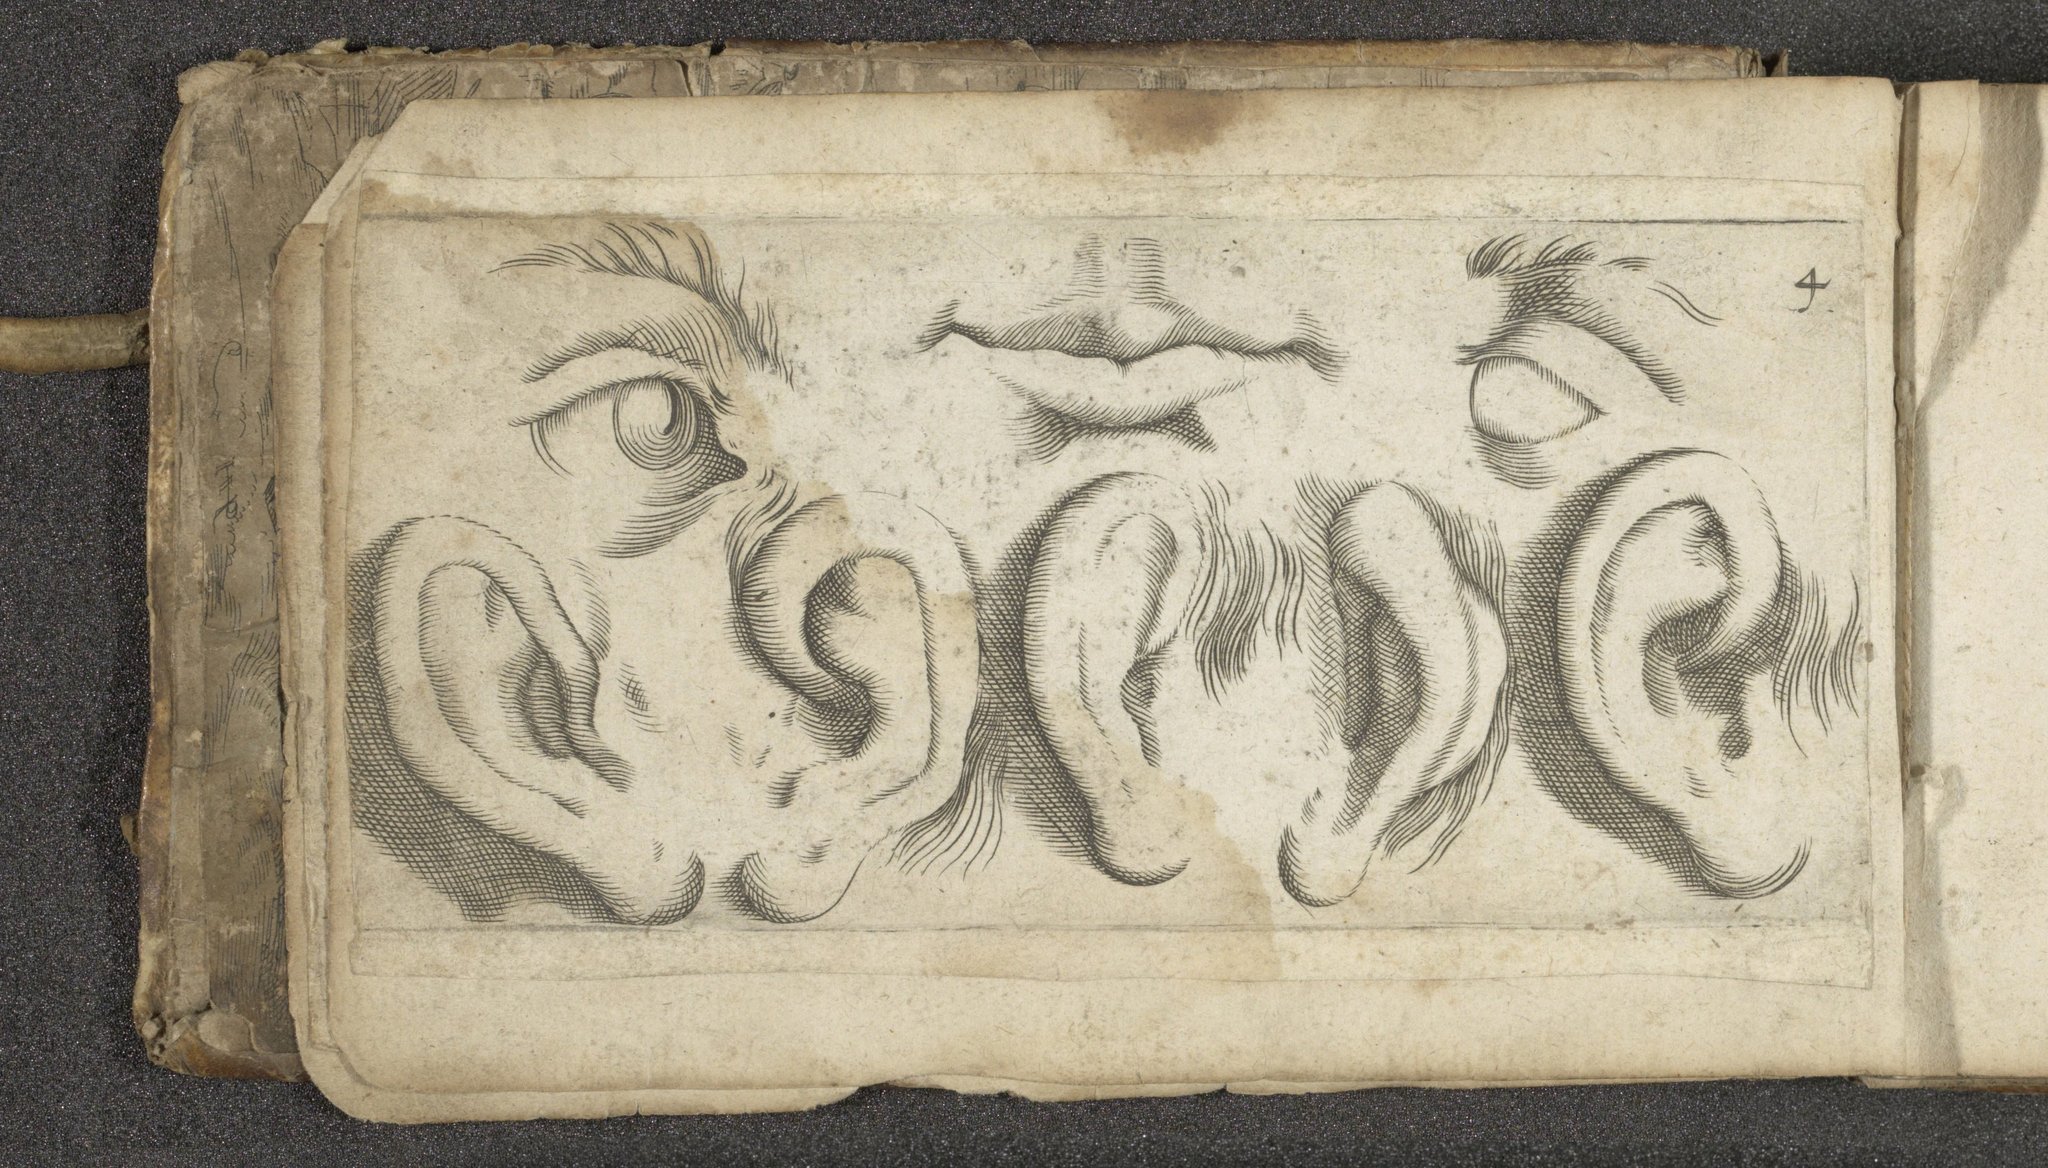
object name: print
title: Vijf oren, twee ogen en een mond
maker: Anonymous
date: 1576-1650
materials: paper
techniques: engraving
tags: parts of the face: lips, eyes, ears, mouth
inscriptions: inscription: ‘16’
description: Vijf oren, twee ogen en een mond. Rechtsboven genummerd: 4. De prent maakt deel uit van een album.